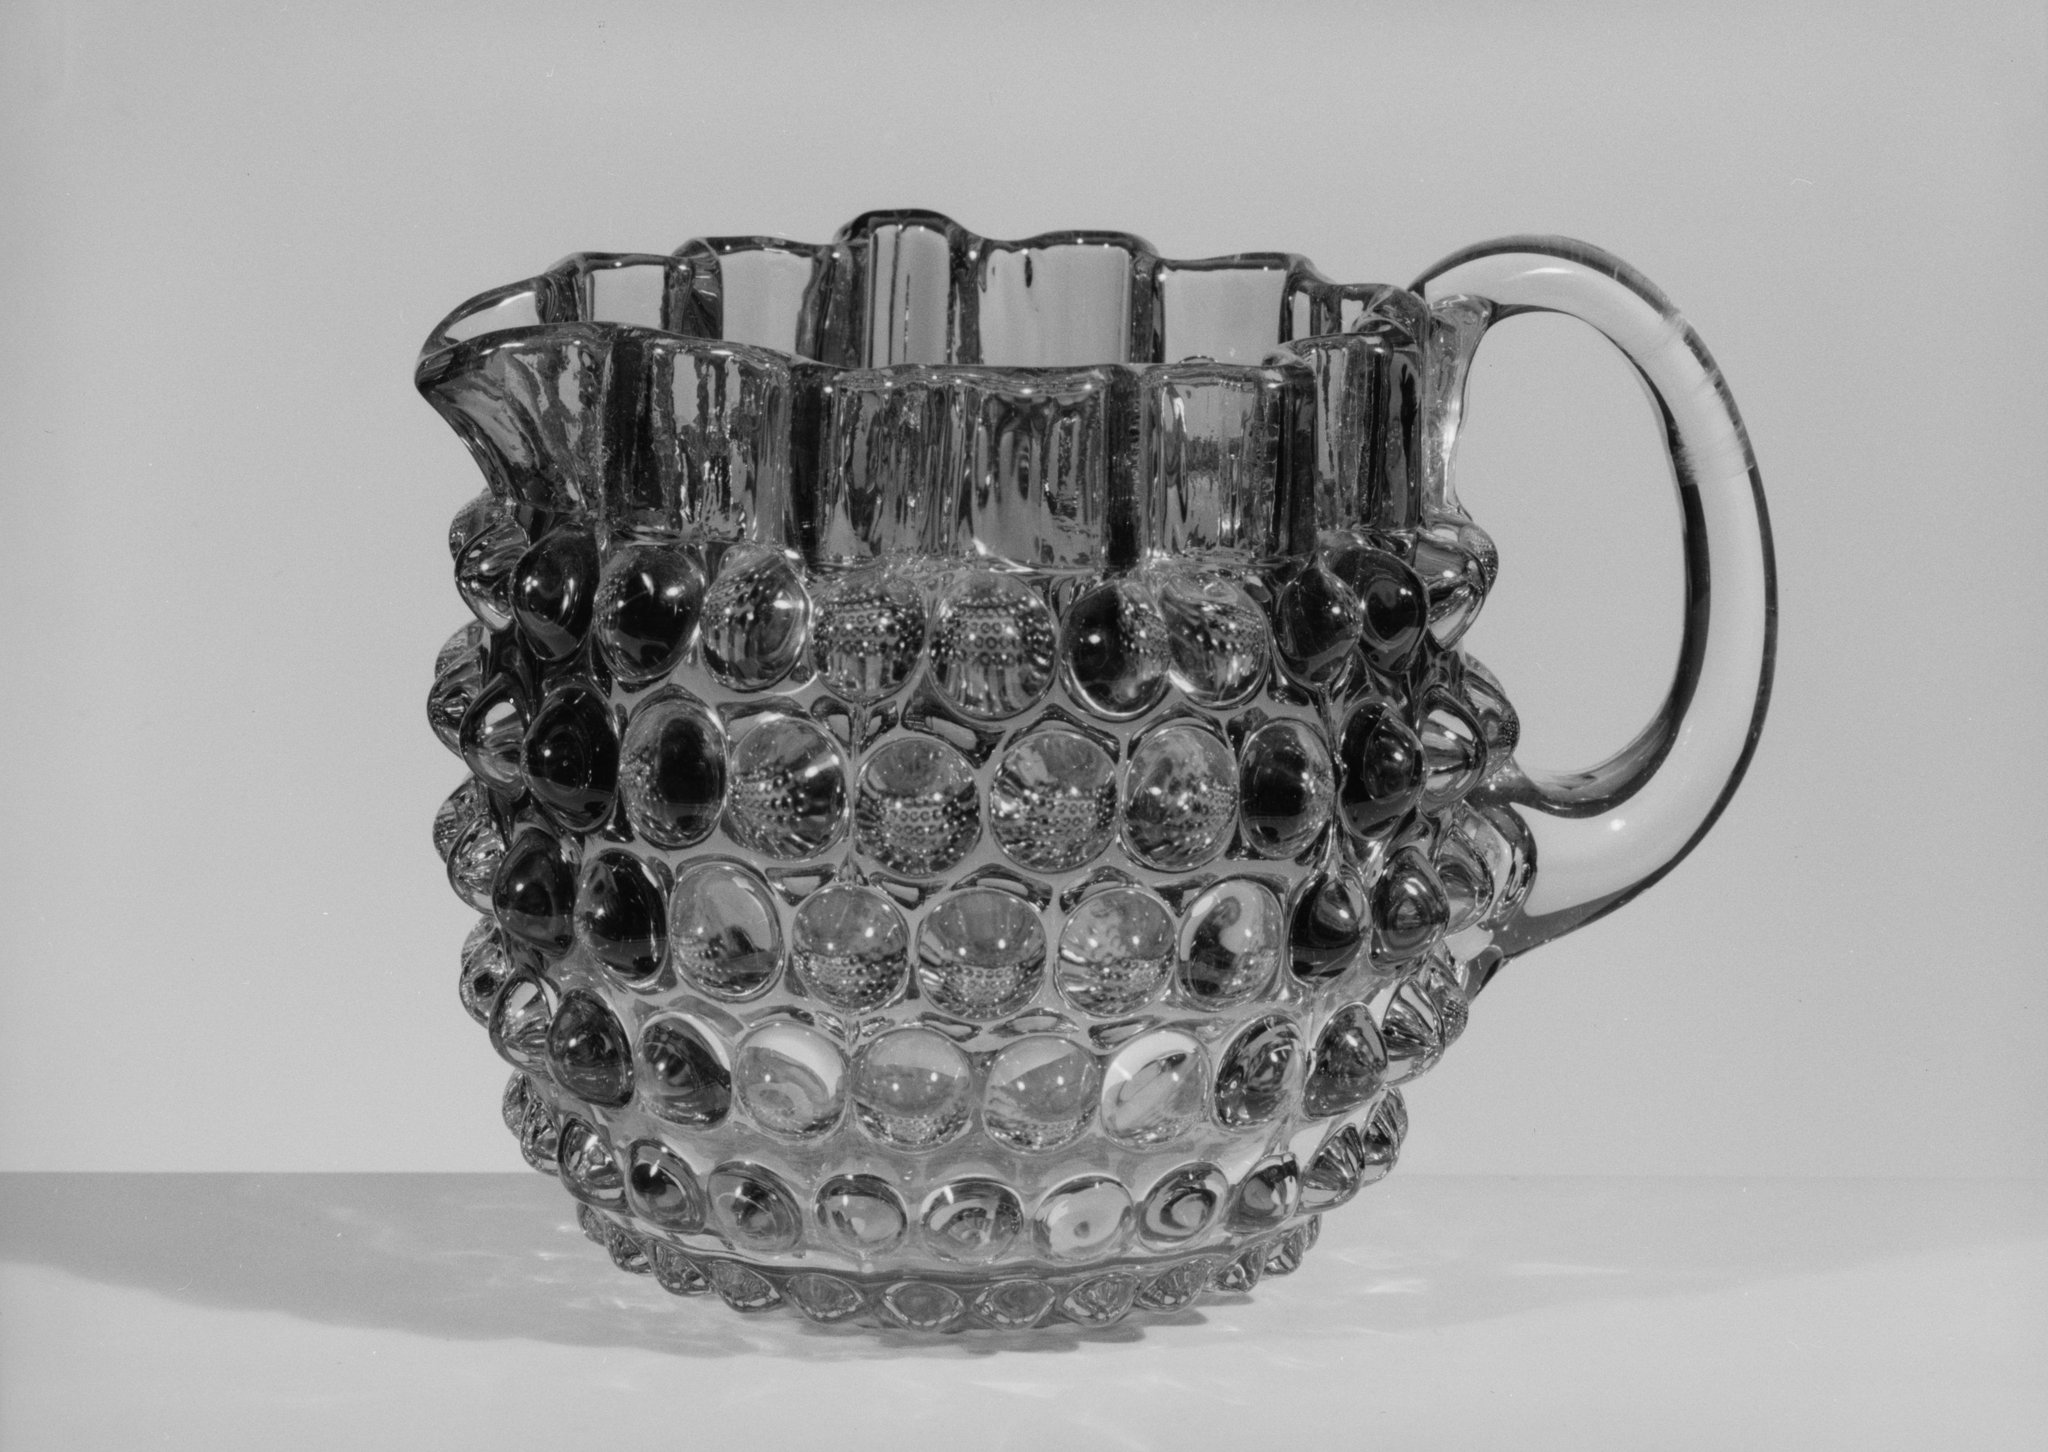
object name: cream pot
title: Hobnail Creamer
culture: american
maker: hobbs, brockunier and company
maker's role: maker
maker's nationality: american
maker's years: 1863-1891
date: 1886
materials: glass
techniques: pressed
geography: united states